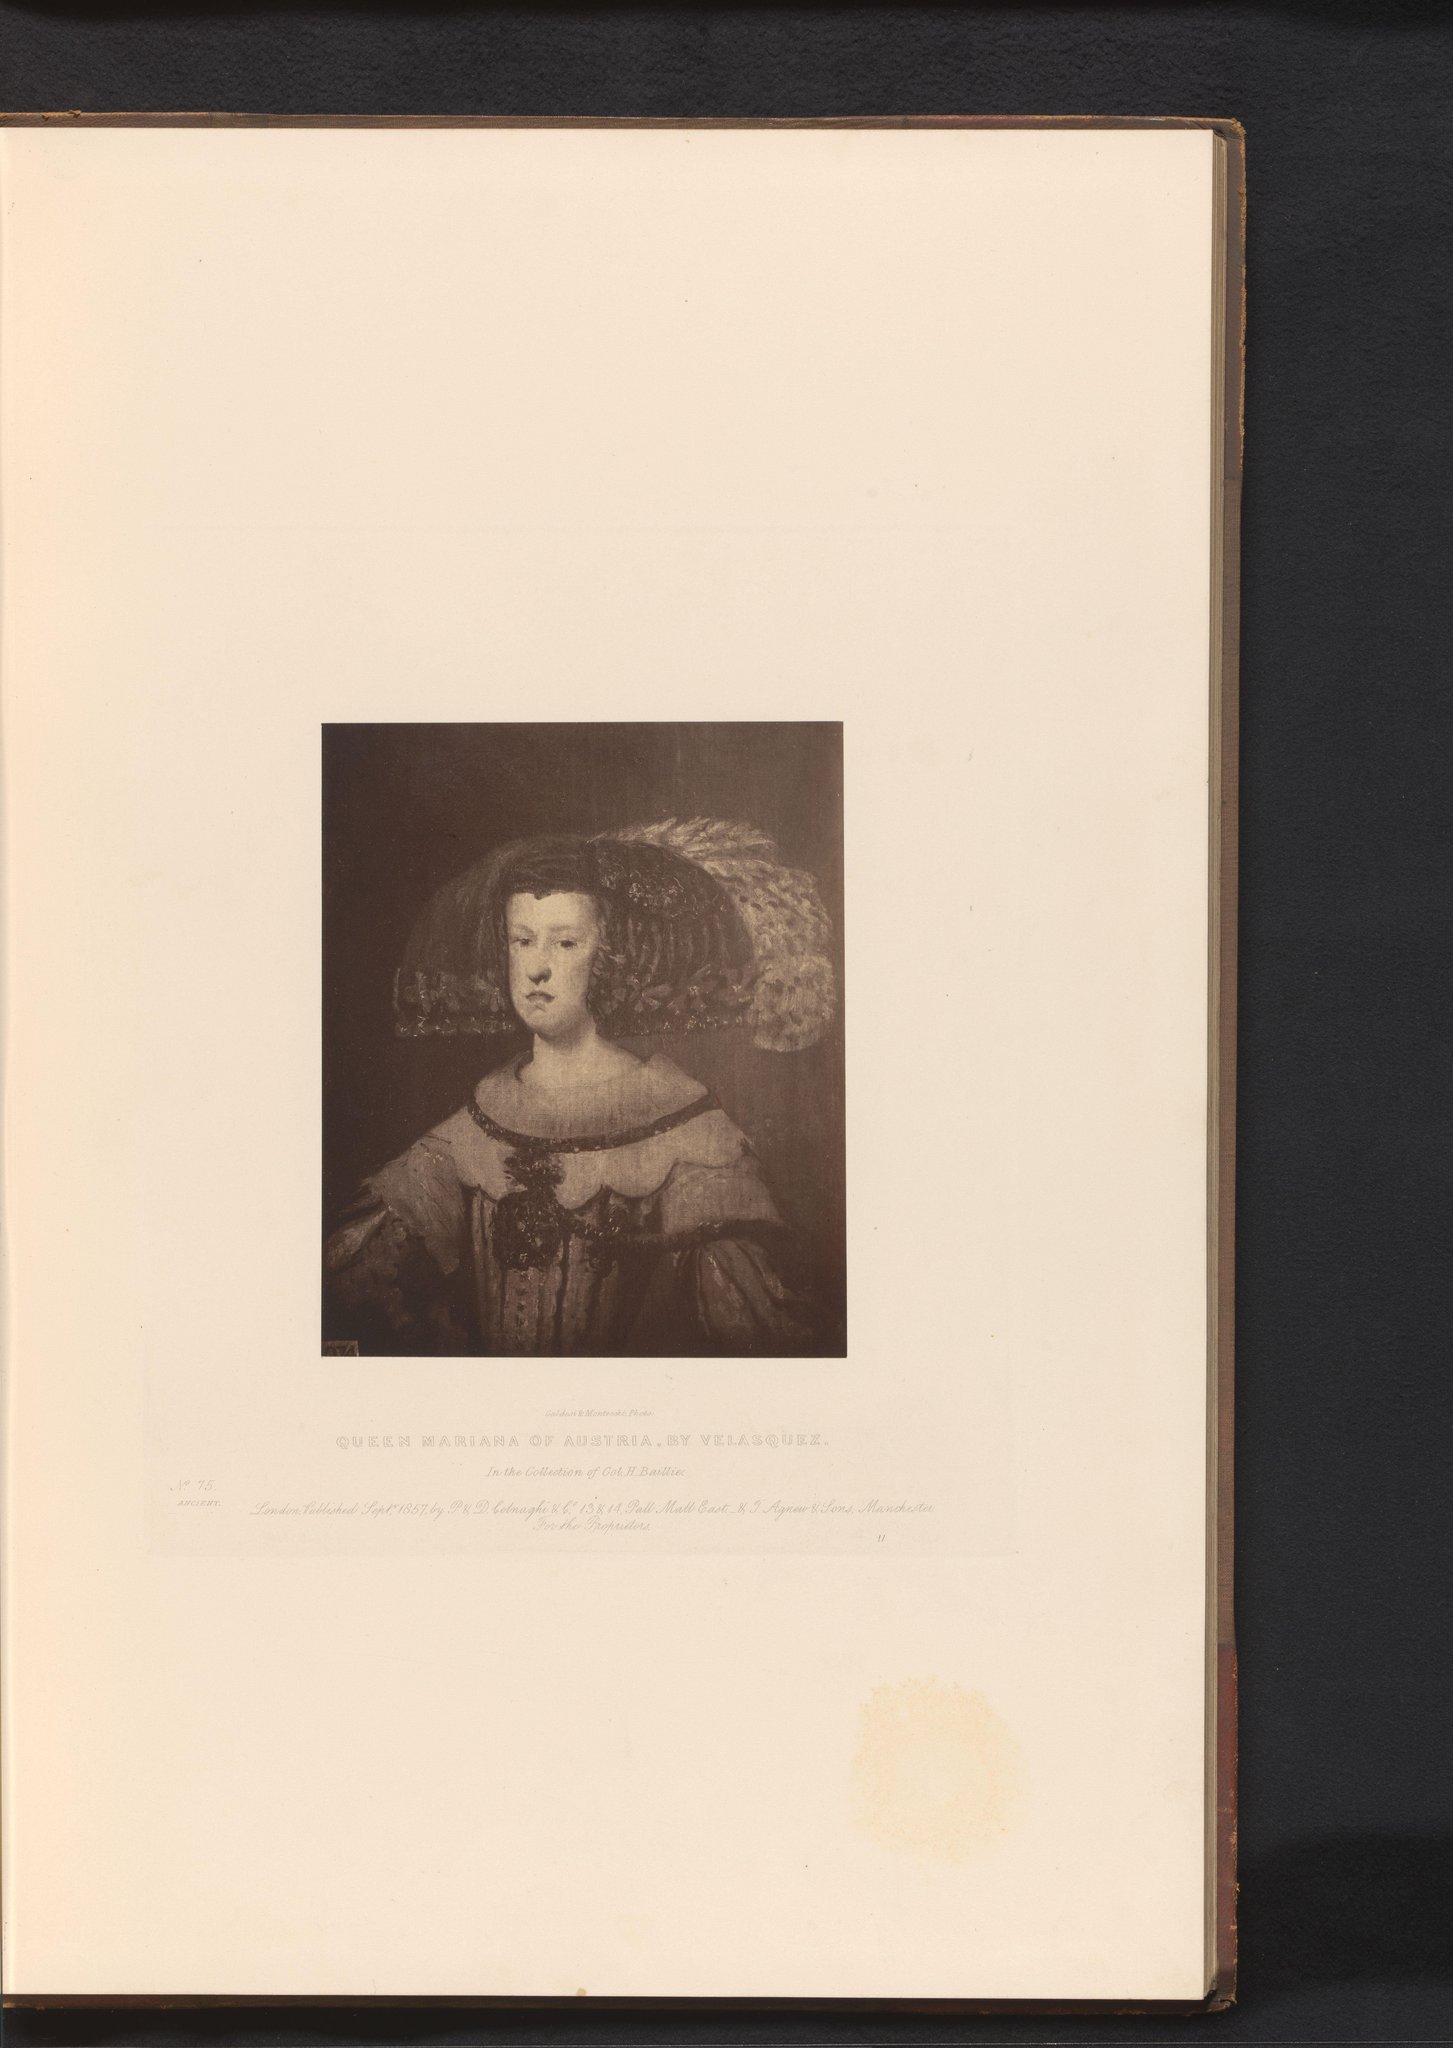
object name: reproduction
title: Queen Mariana of Austria, by Velasquez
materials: photographic support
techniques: albumen print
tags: vienna, maria anna van oostenrijk (koningin van spanje), historical persons - bb - woman, queen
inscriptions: number: ‘No. 75./ ANCIENT.’, number: ‘11’, inscription: ‘In the Collection of Col. H. Baillie./ London, Published Septr, 1857, by P. & D. Colnaghi & Co, 13 & 14, Pall Mall East/ & T. Agneur & Sons, Manchester. For the Proprietors.’